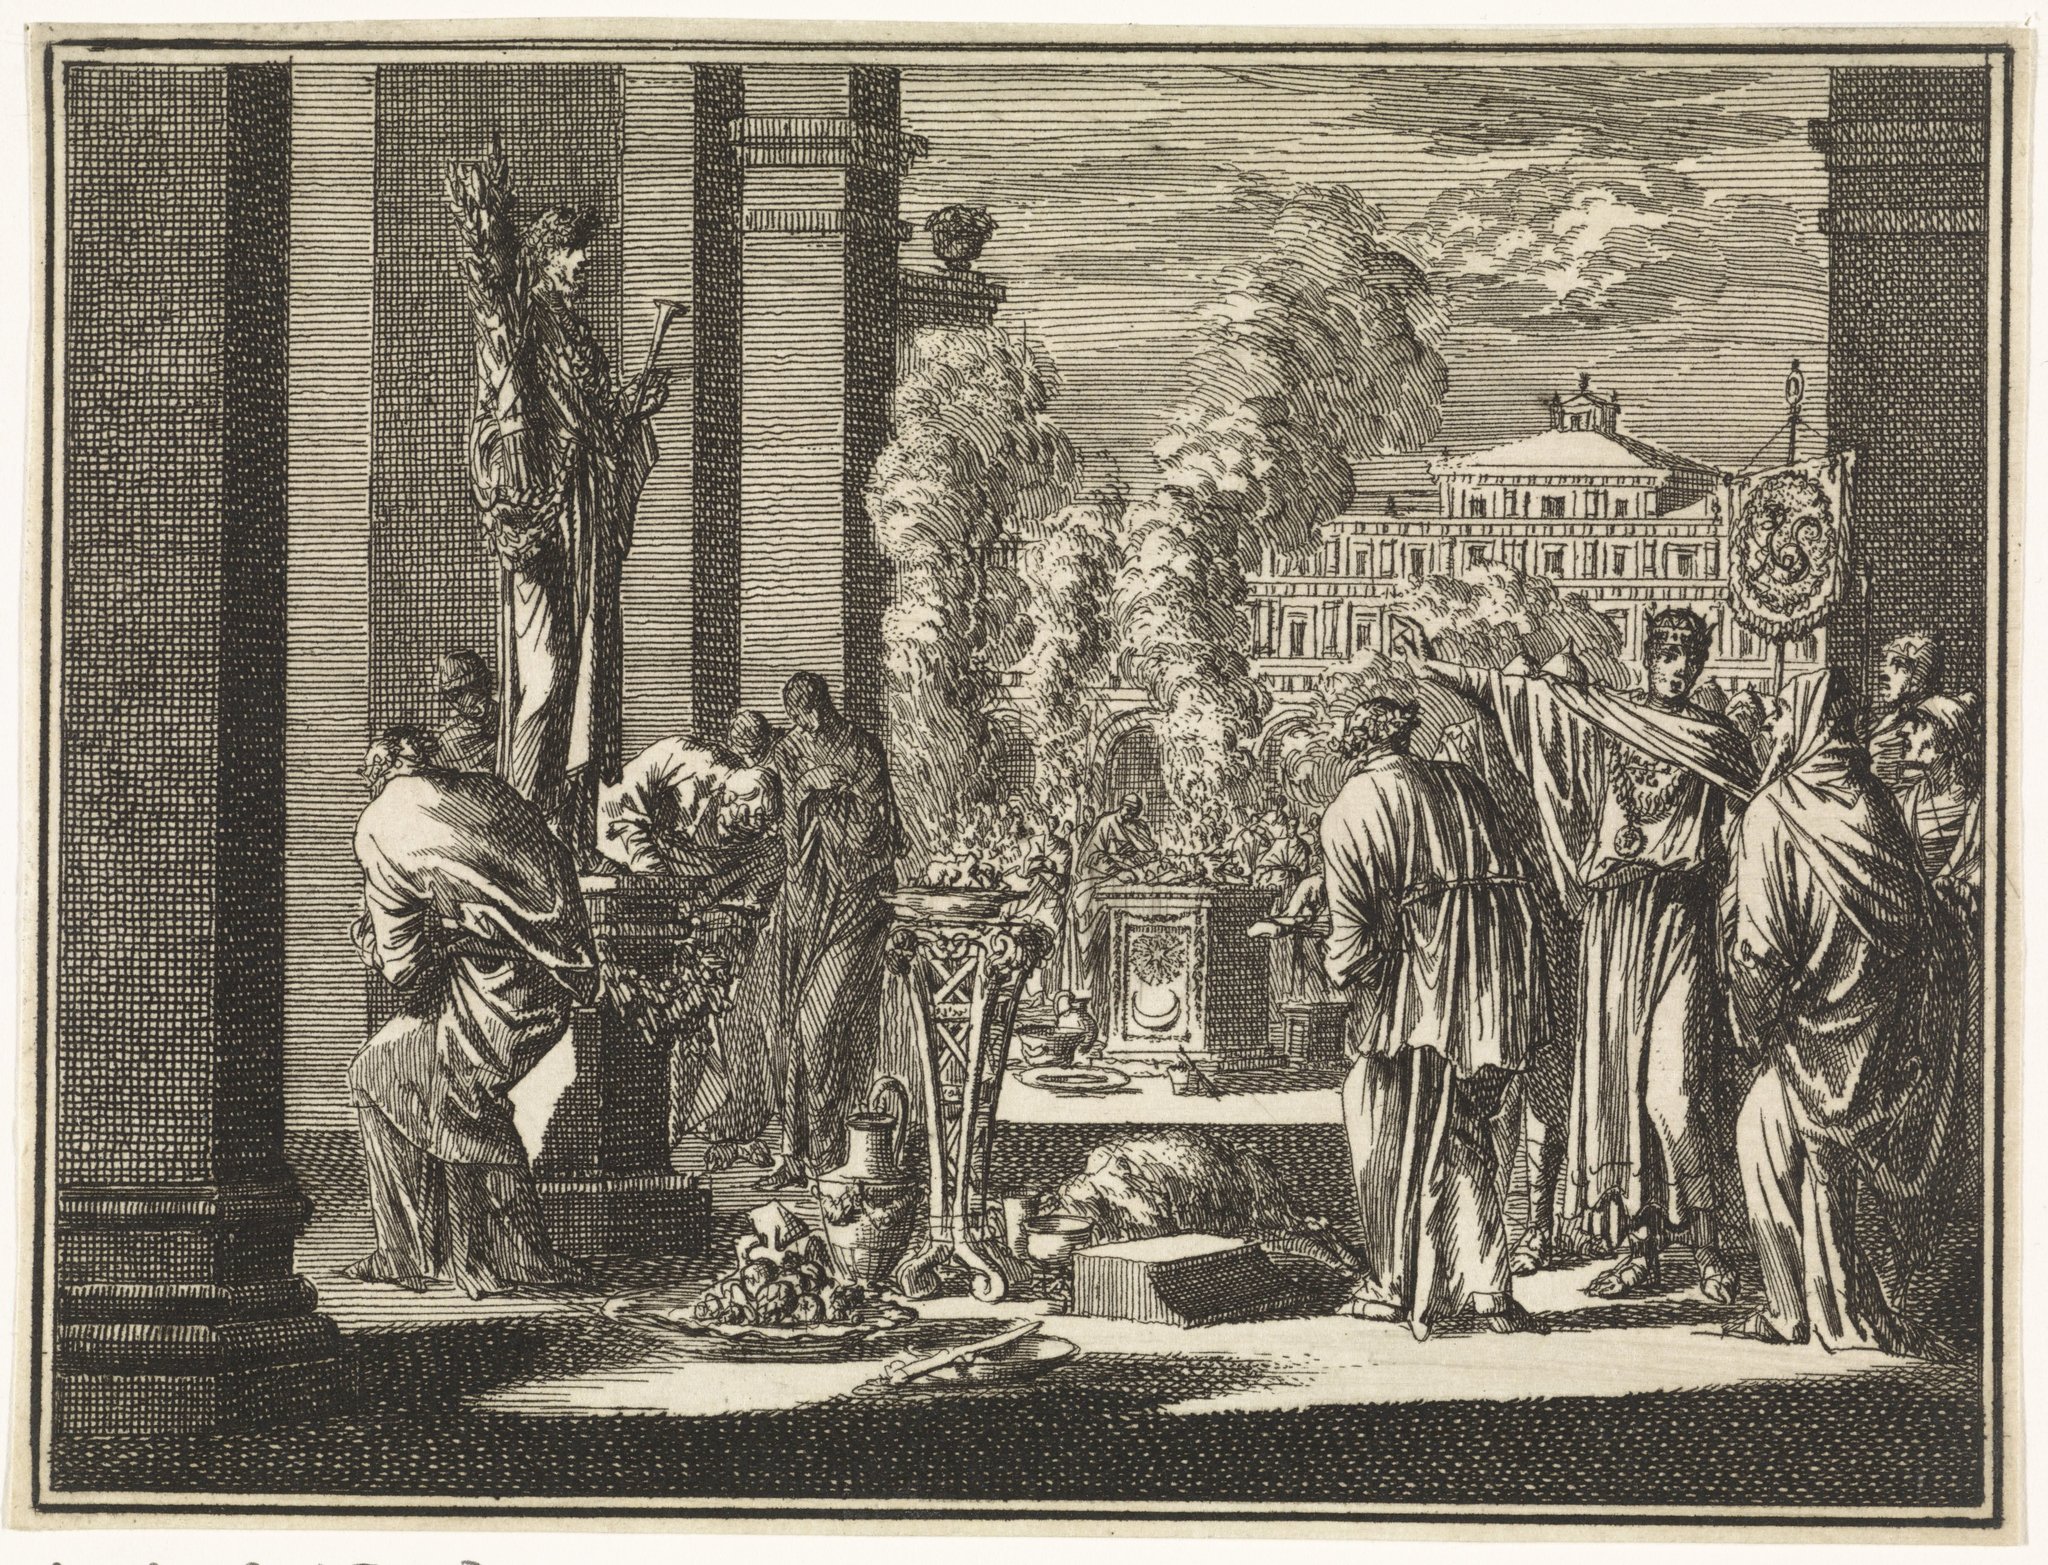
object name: print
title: Koning Manasse vereert een afgodsbeeld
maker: jan luyken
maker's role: draughtsman, print maker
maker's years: 1649-1712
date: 1712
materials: paper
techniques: etching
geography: amsterdam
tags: manasseh's apostasy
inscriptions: collector's mark: Lugt 2228, number: ‘156’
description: Illustratie uit: Luyken, Jan. De schriftuurlyke geschiedenissen en gelykenissen van het Oude en Nieuwe Verbond, 2 delen. Amsterdam: Wed. Pieter Arentsz II en Cornelis van der Sys, 1712, dl. I.